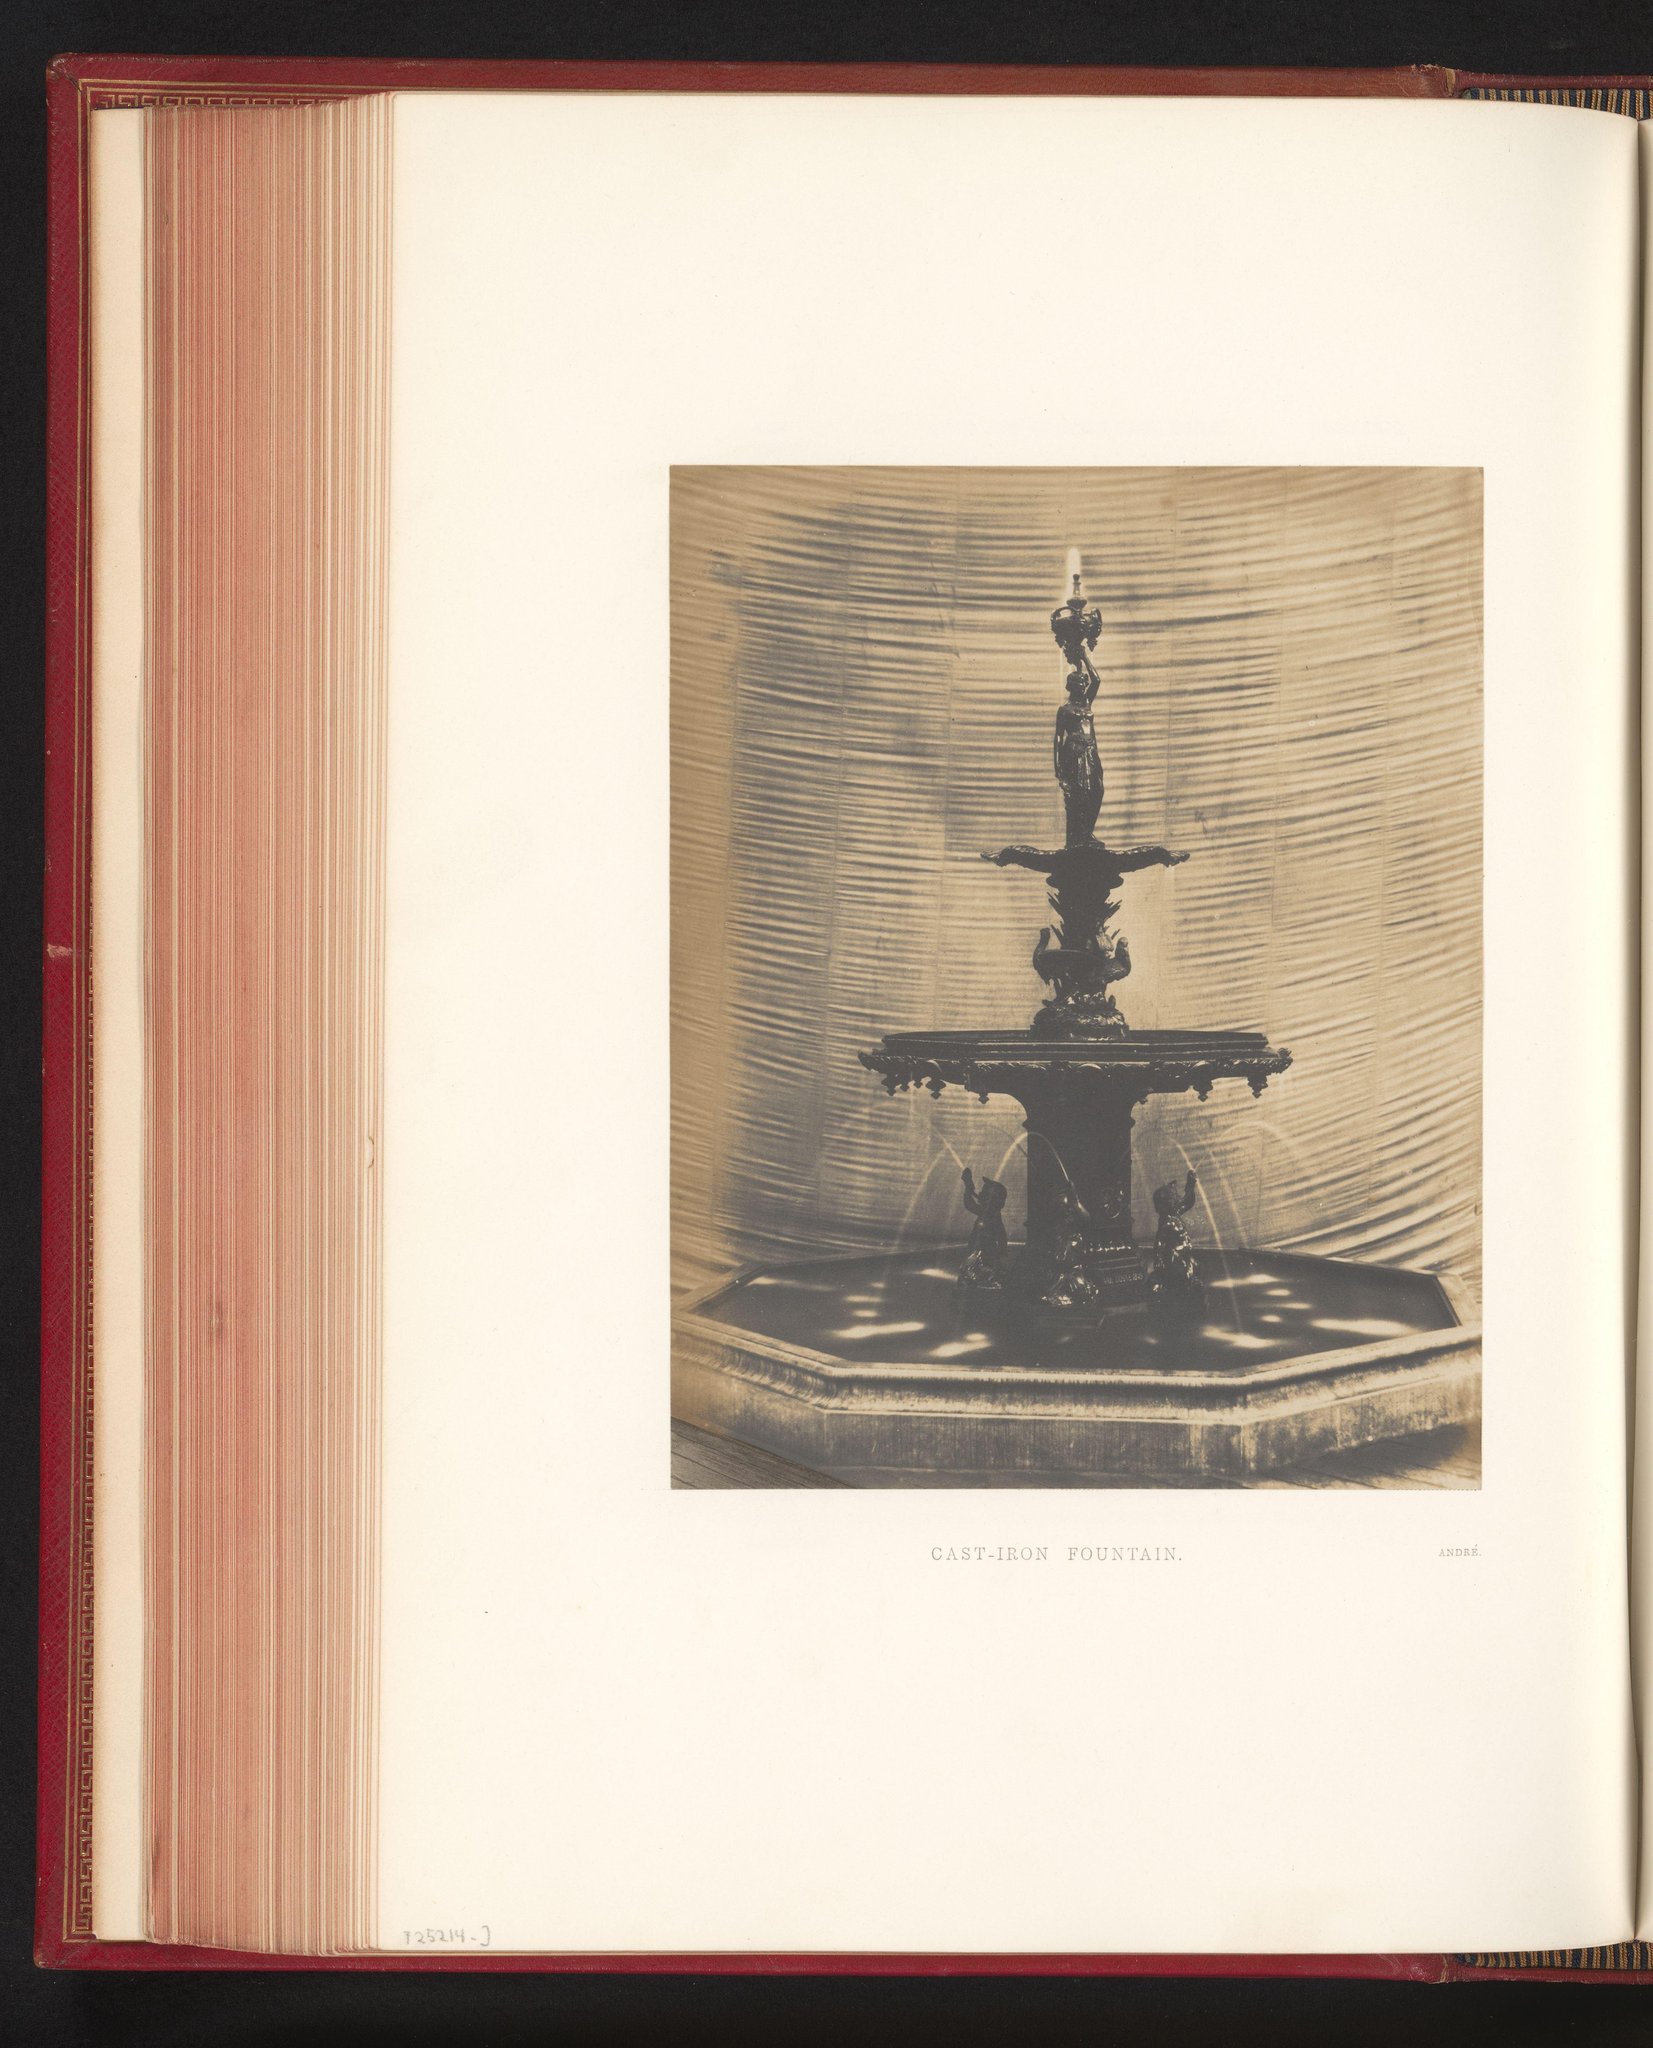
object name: photograph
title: Cast-Iron Fountain. André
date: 1851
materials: photographic support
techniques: salted paper print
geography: london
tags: ornamental fountain, london